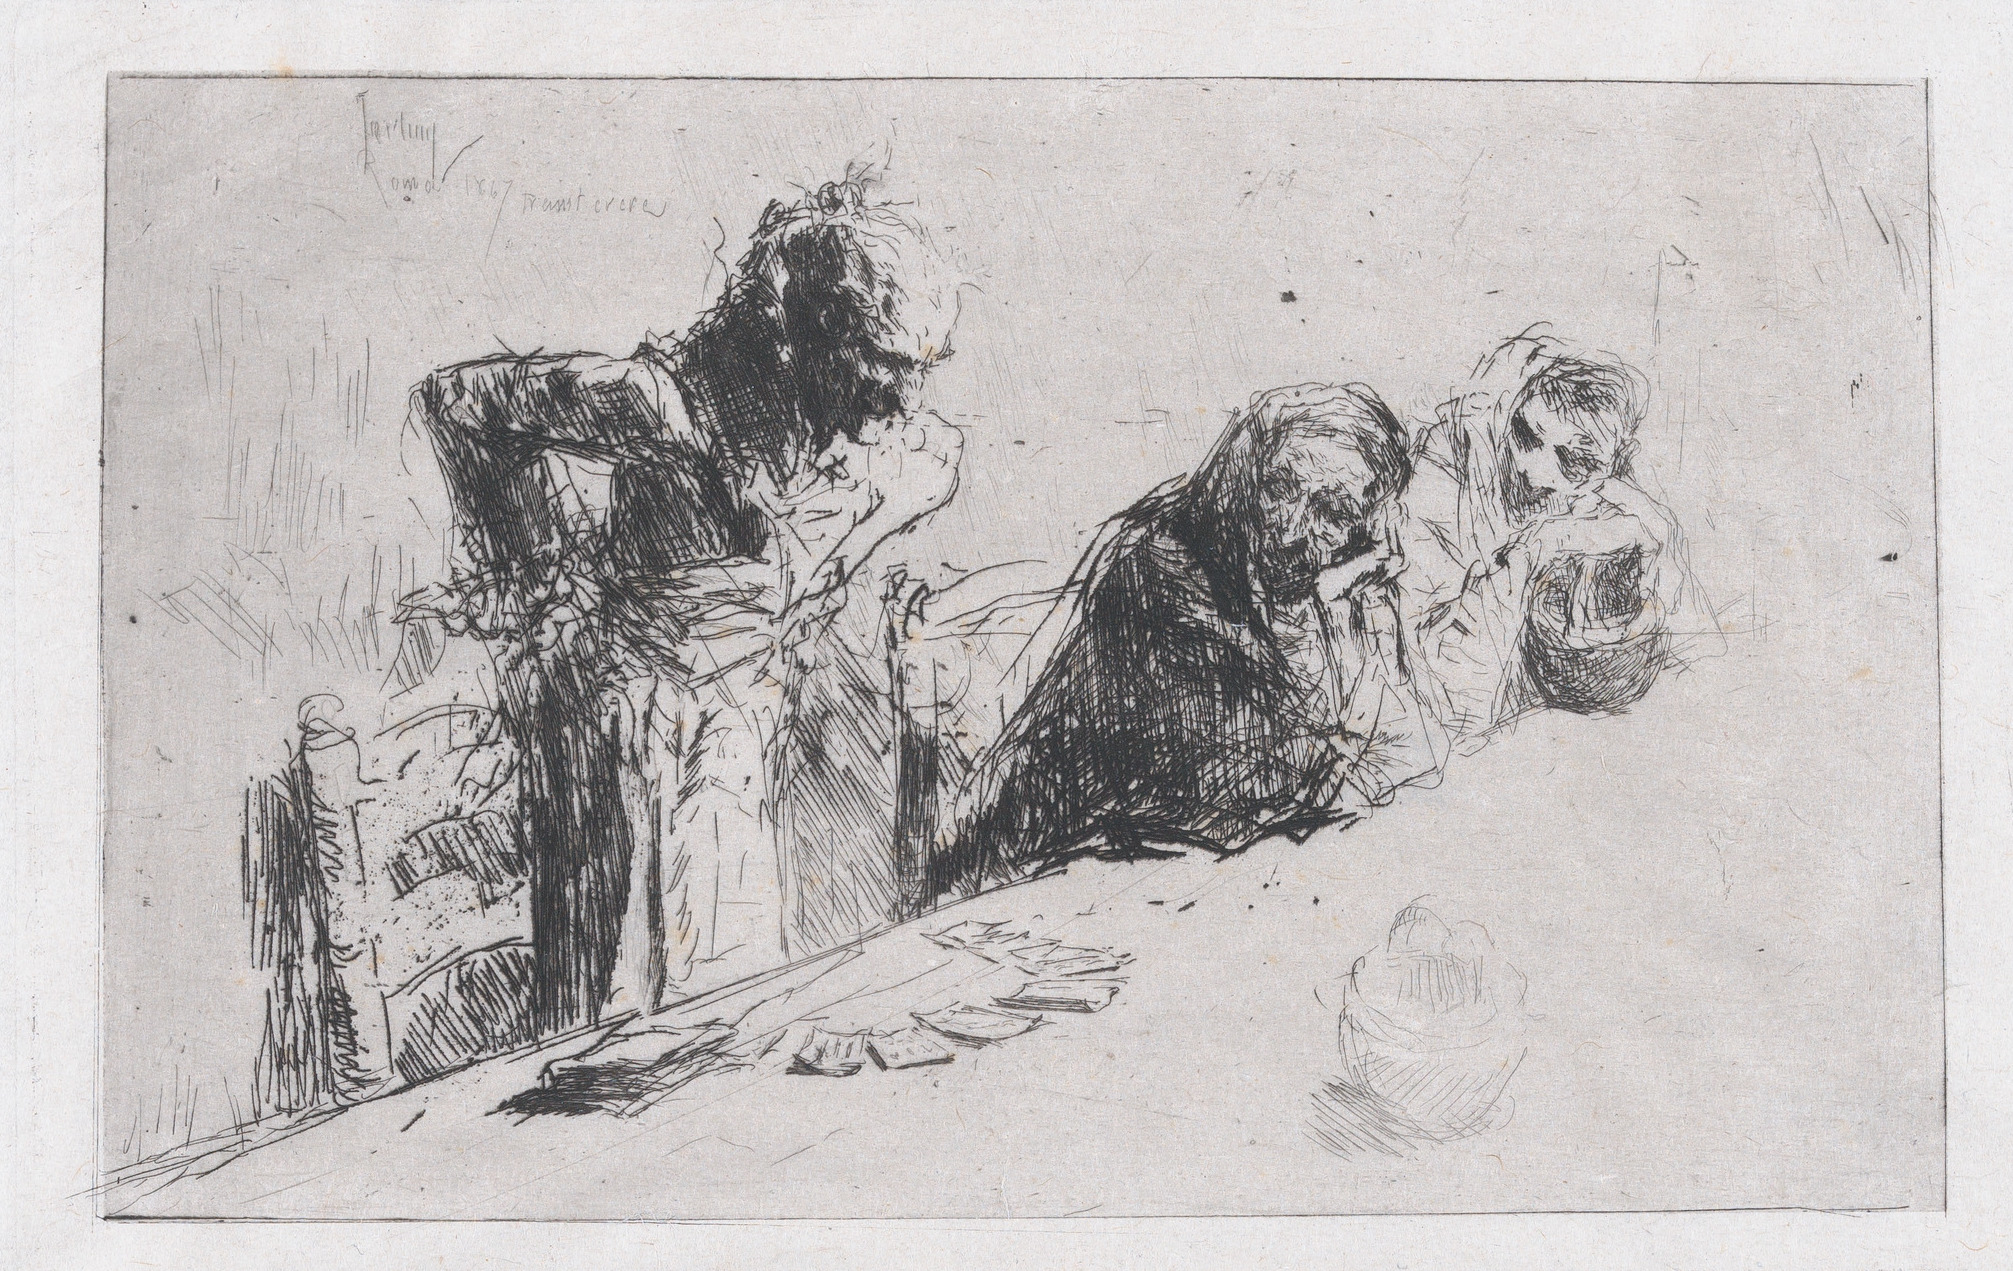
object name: print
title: Cardplayers: three men, two seated one standing before a spread of cards on a table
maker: mariano fortuny, 1838–1874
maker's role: artist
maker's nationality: spanish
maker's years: 1838-1874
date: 1867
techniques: etching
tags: men,playing cards